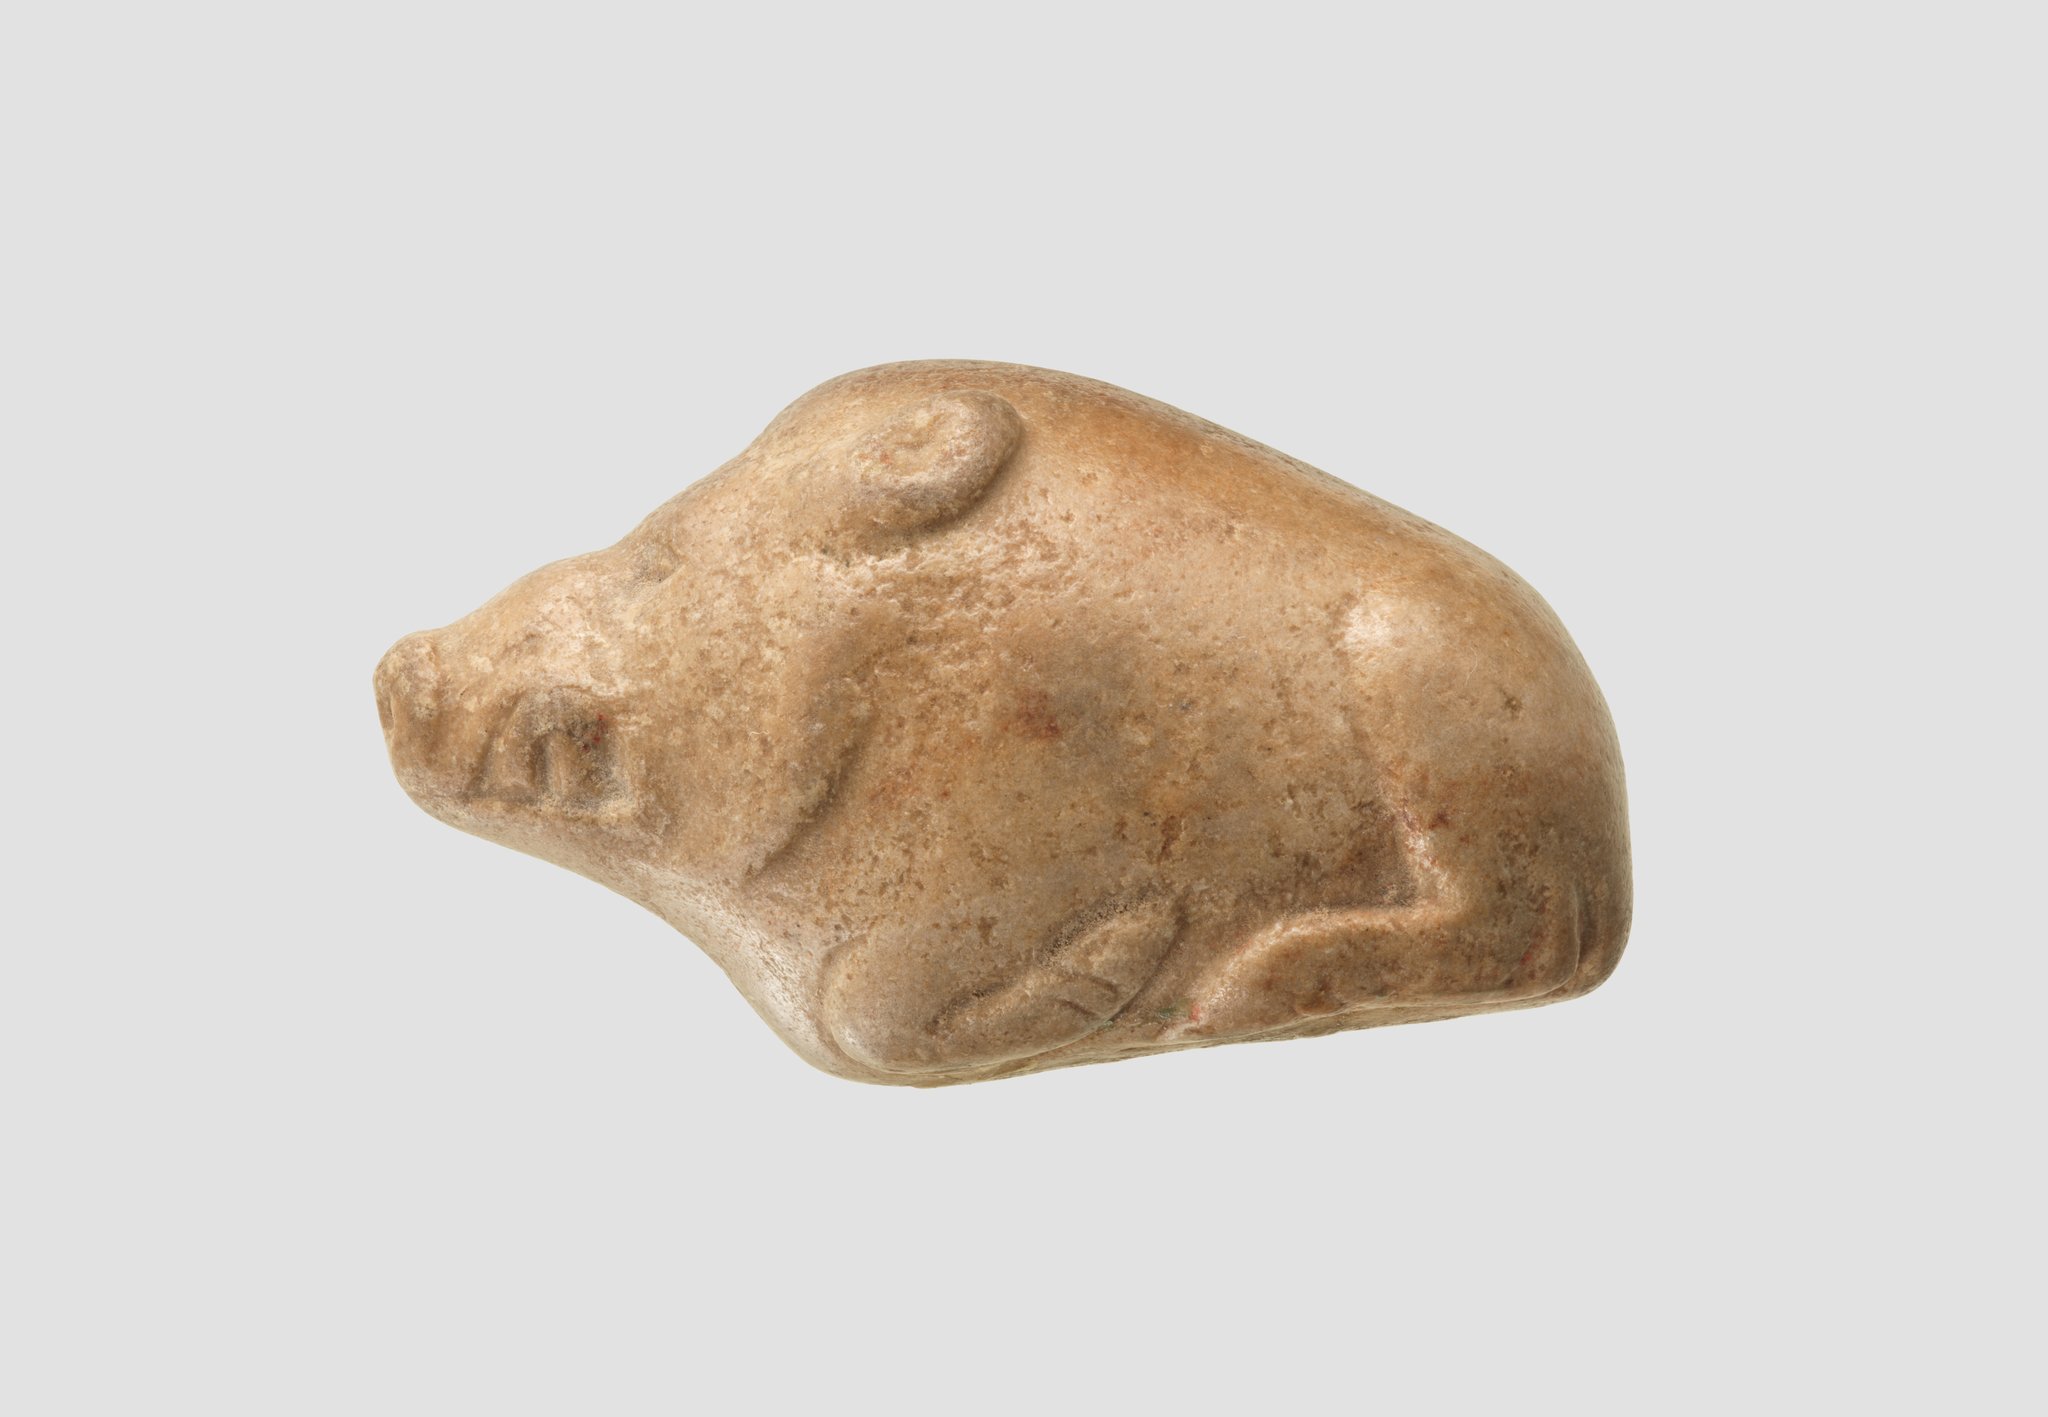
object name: weight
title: Weight (?)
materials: stone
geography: mesopotamia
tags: boars